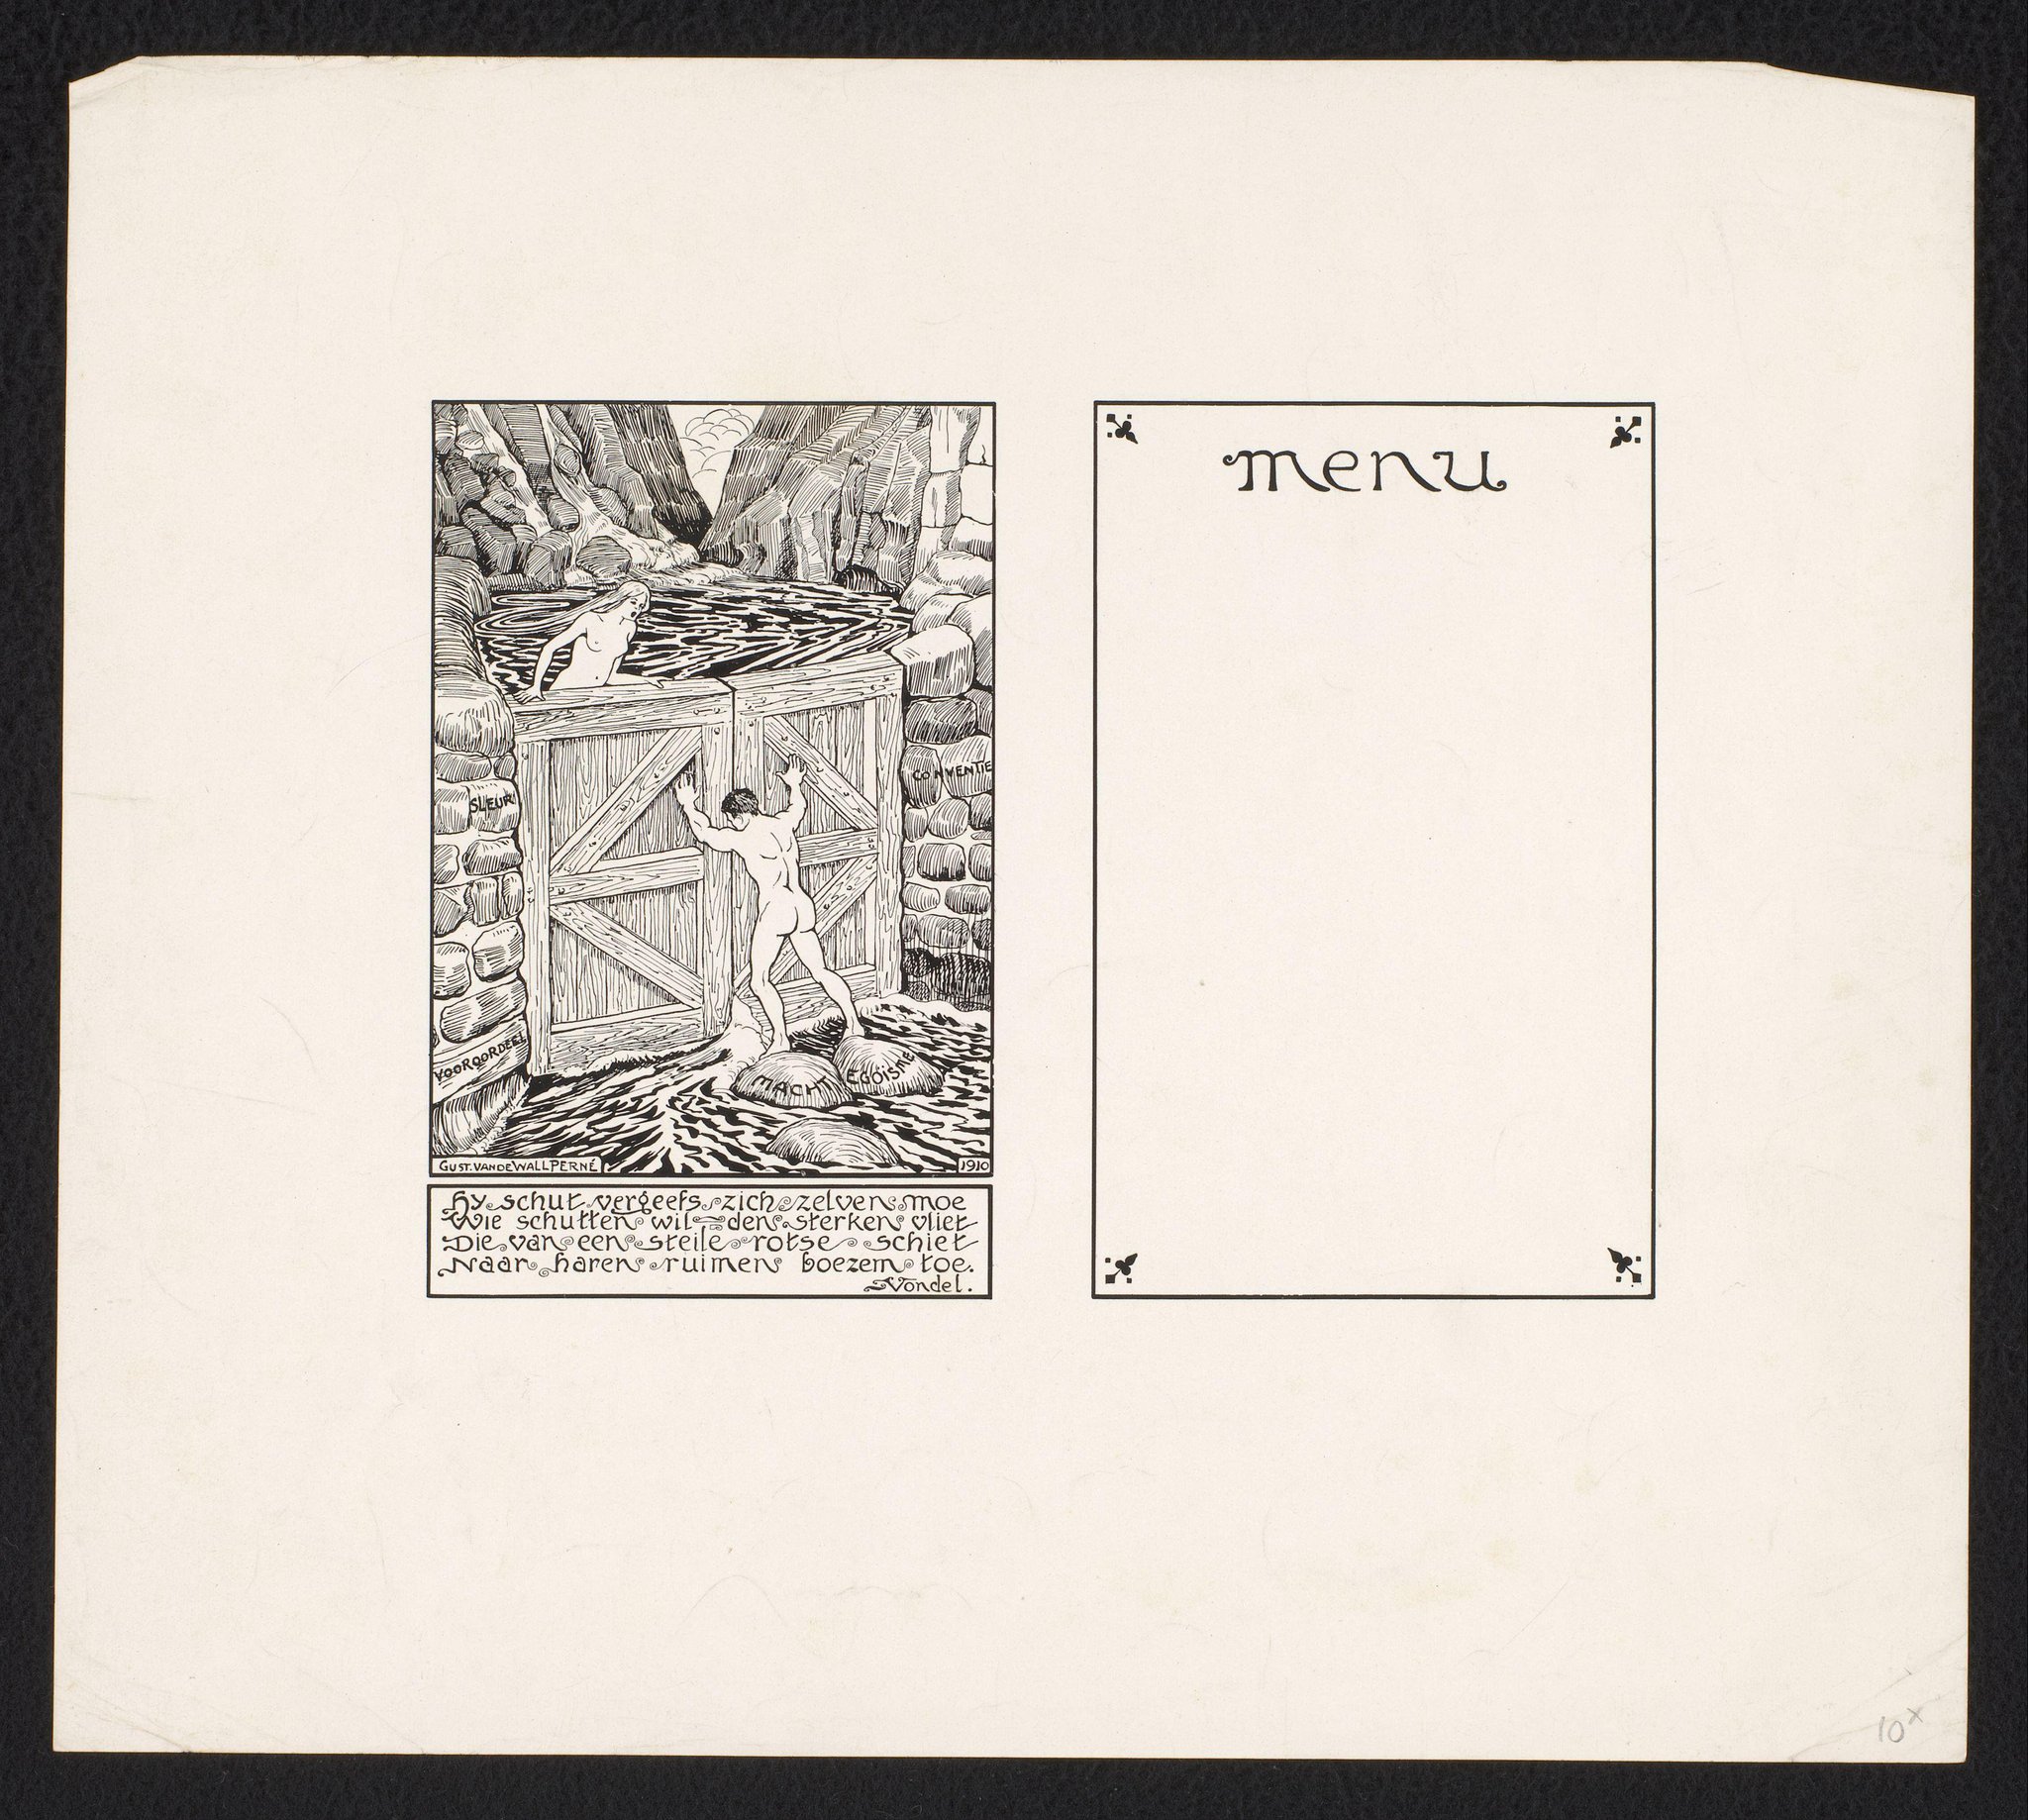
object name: menu, menukaart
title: Menukaart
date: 1878-1911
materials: paper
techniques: printing block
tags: sluice, weir, woman (showing herself) undressed, quasi-nude, man (showing himself) undressed, quasi-nude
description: Links een naakte man staand op twee rotsen in een rivier. Op de rotsen 'macht' en 'egoïsme'. De man houdt de deuren van een stuwmeer dicht, waarachter een naakte vrouw. Onder de afbeelding: 'Hij schut vergeefs zichzelven moe wie schutten wil den sterken vliet die van een steile rotse schiet naar haren ruimen boezem toe. Vondel'. Het menu is niet ingevuld.